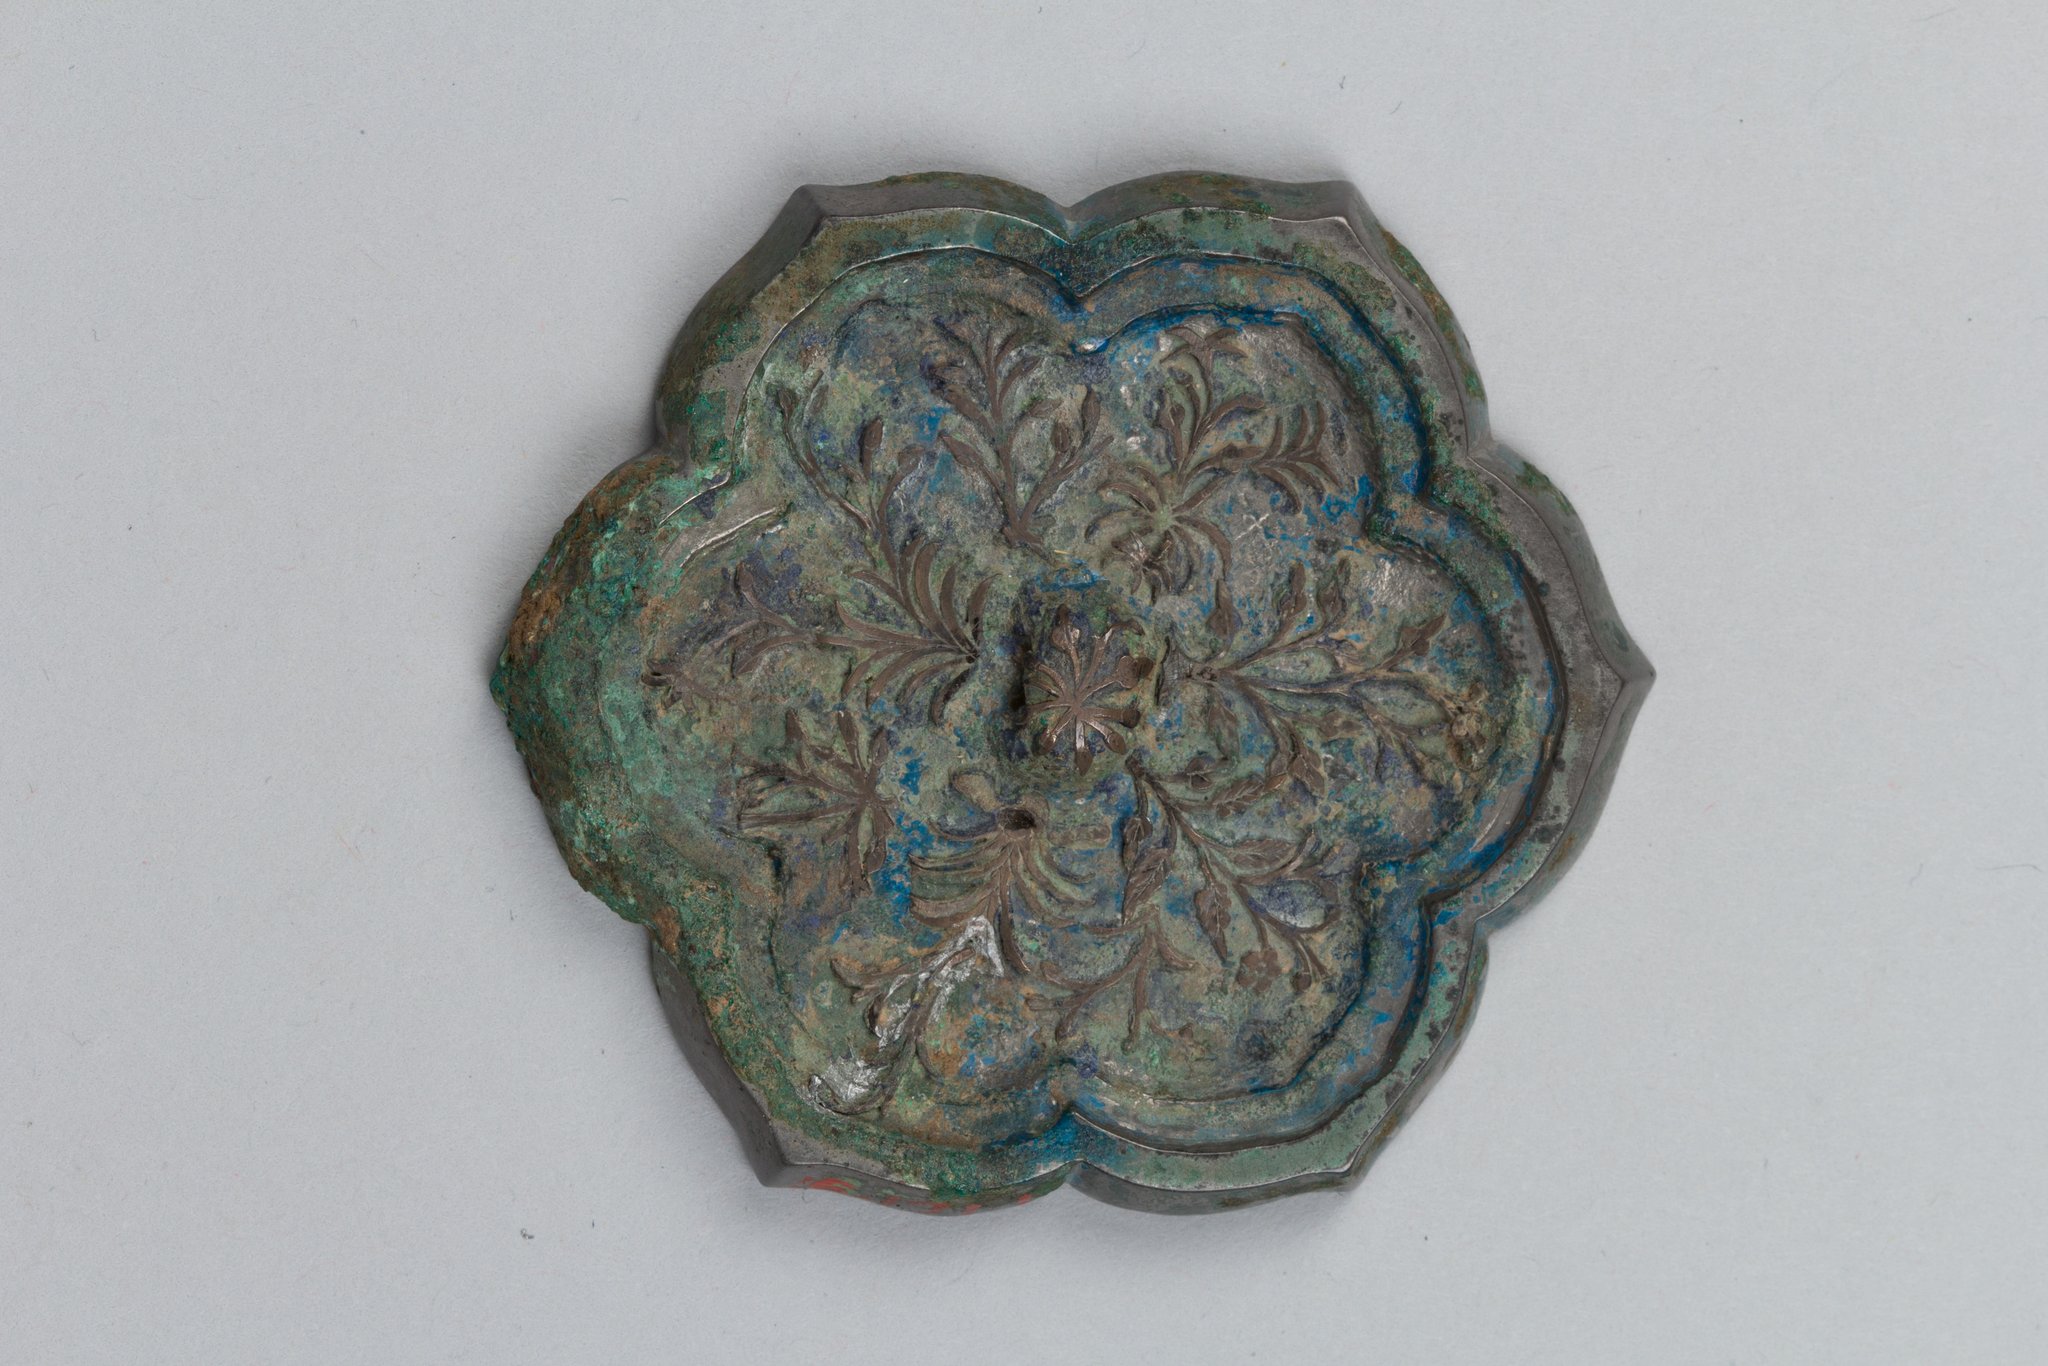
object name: mirror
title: Mirror with floral designs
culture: chinese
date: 701-800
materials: bronze, silver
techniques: inlay